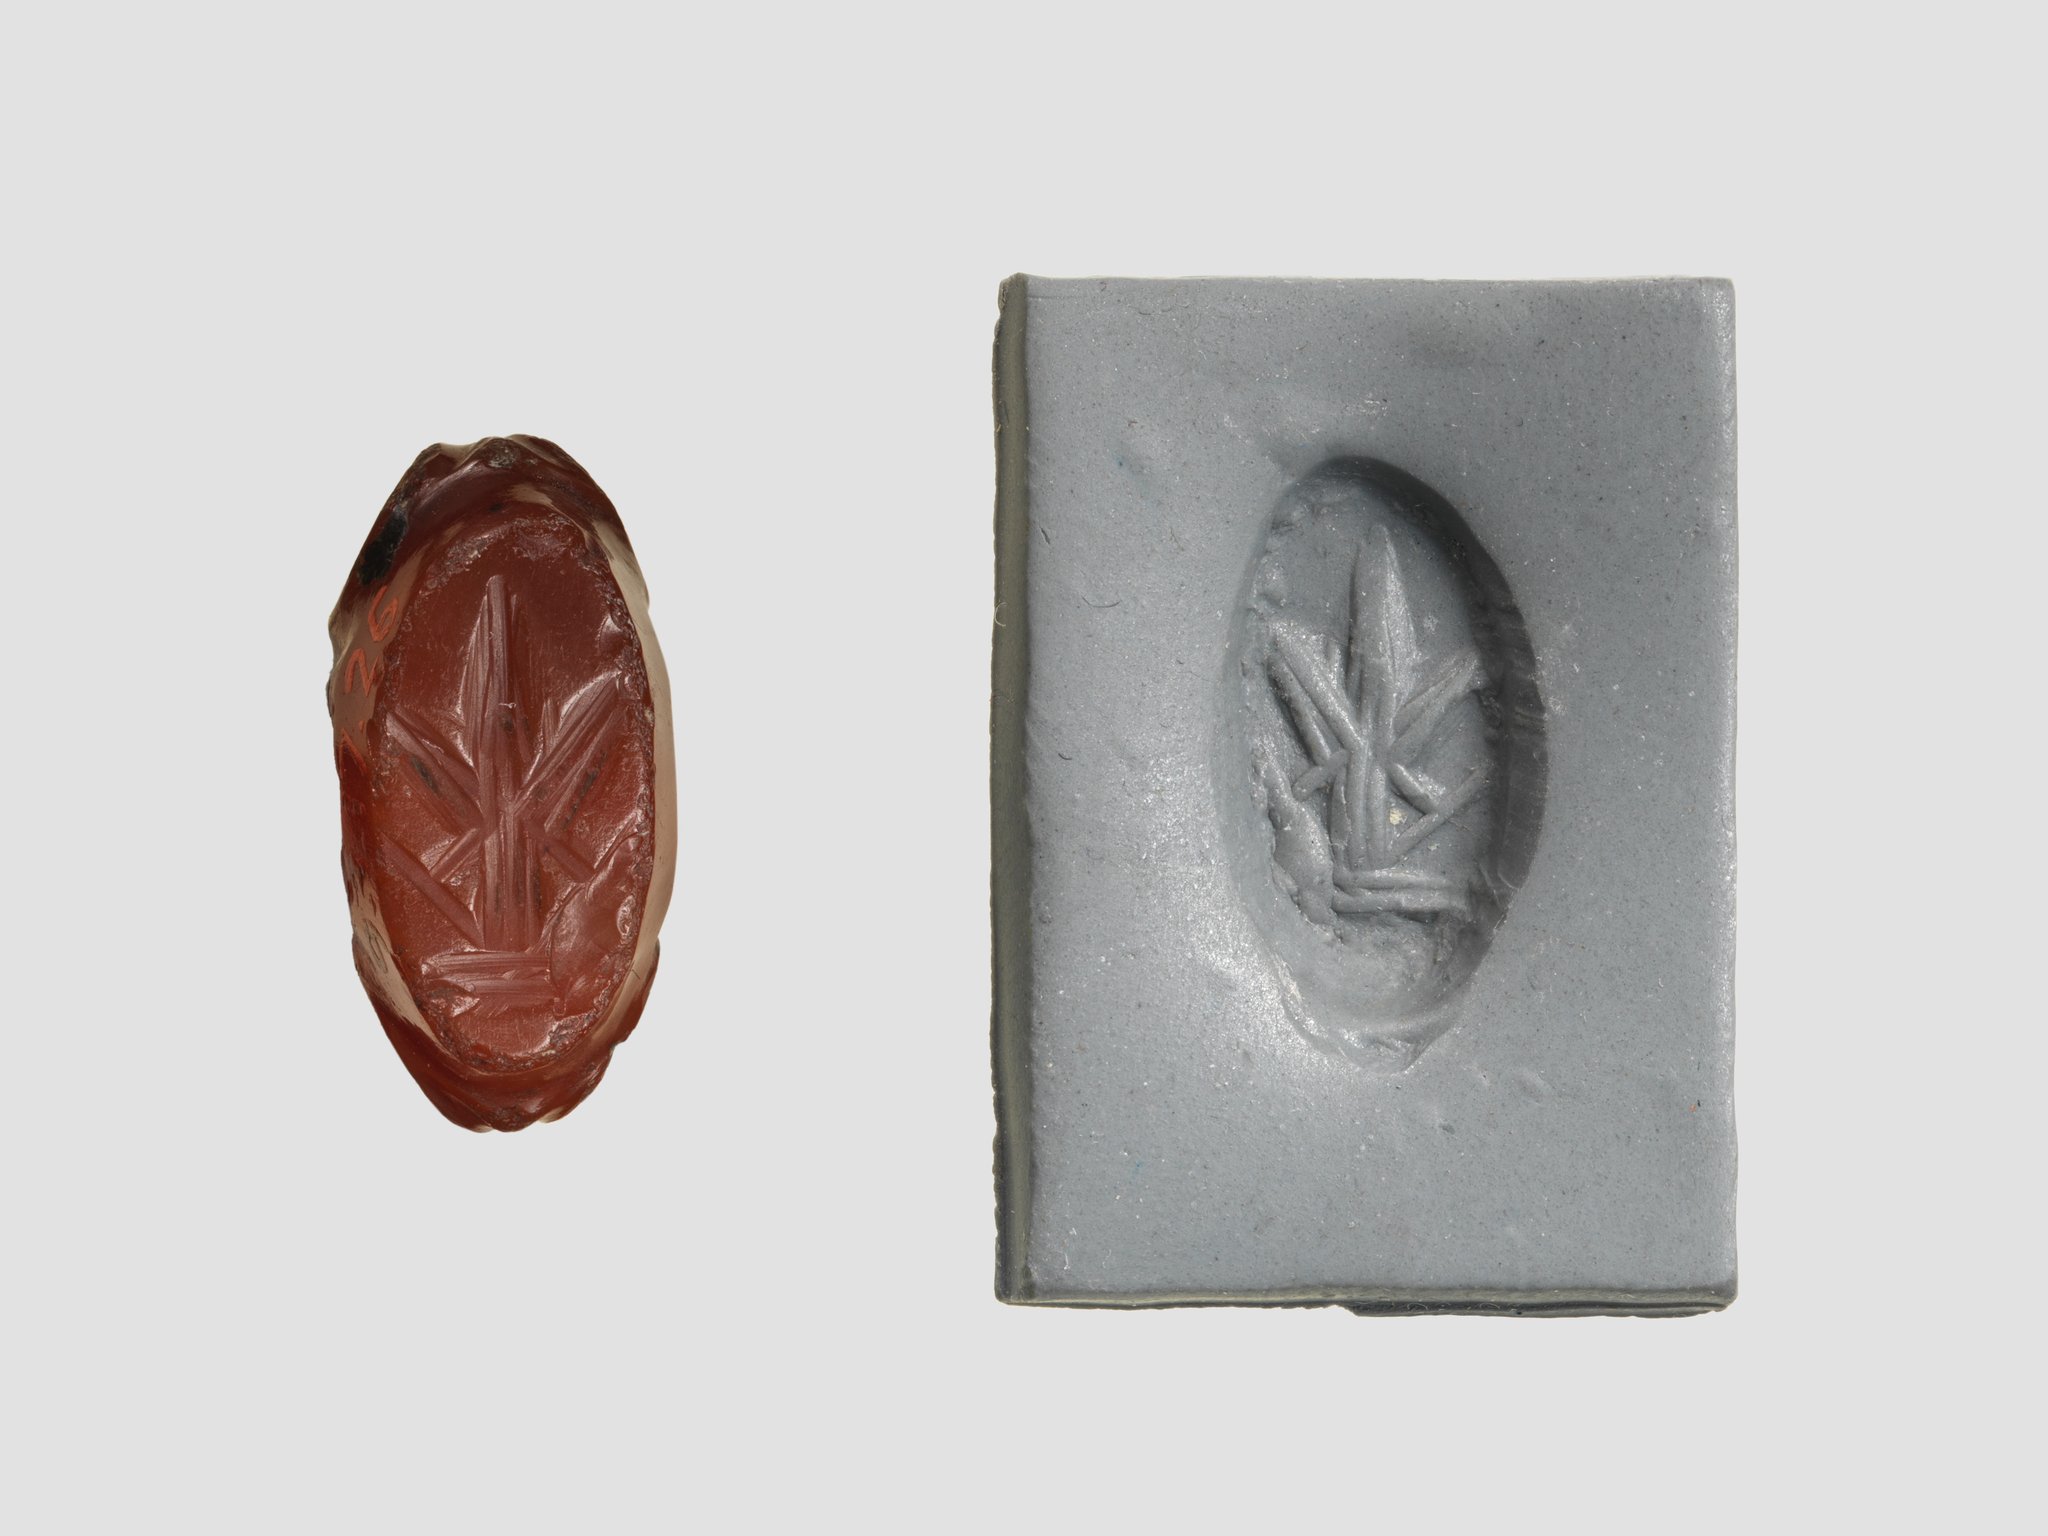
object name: stamp seal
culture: sasanian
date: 201-700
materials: stone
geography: iran or mesopotamia